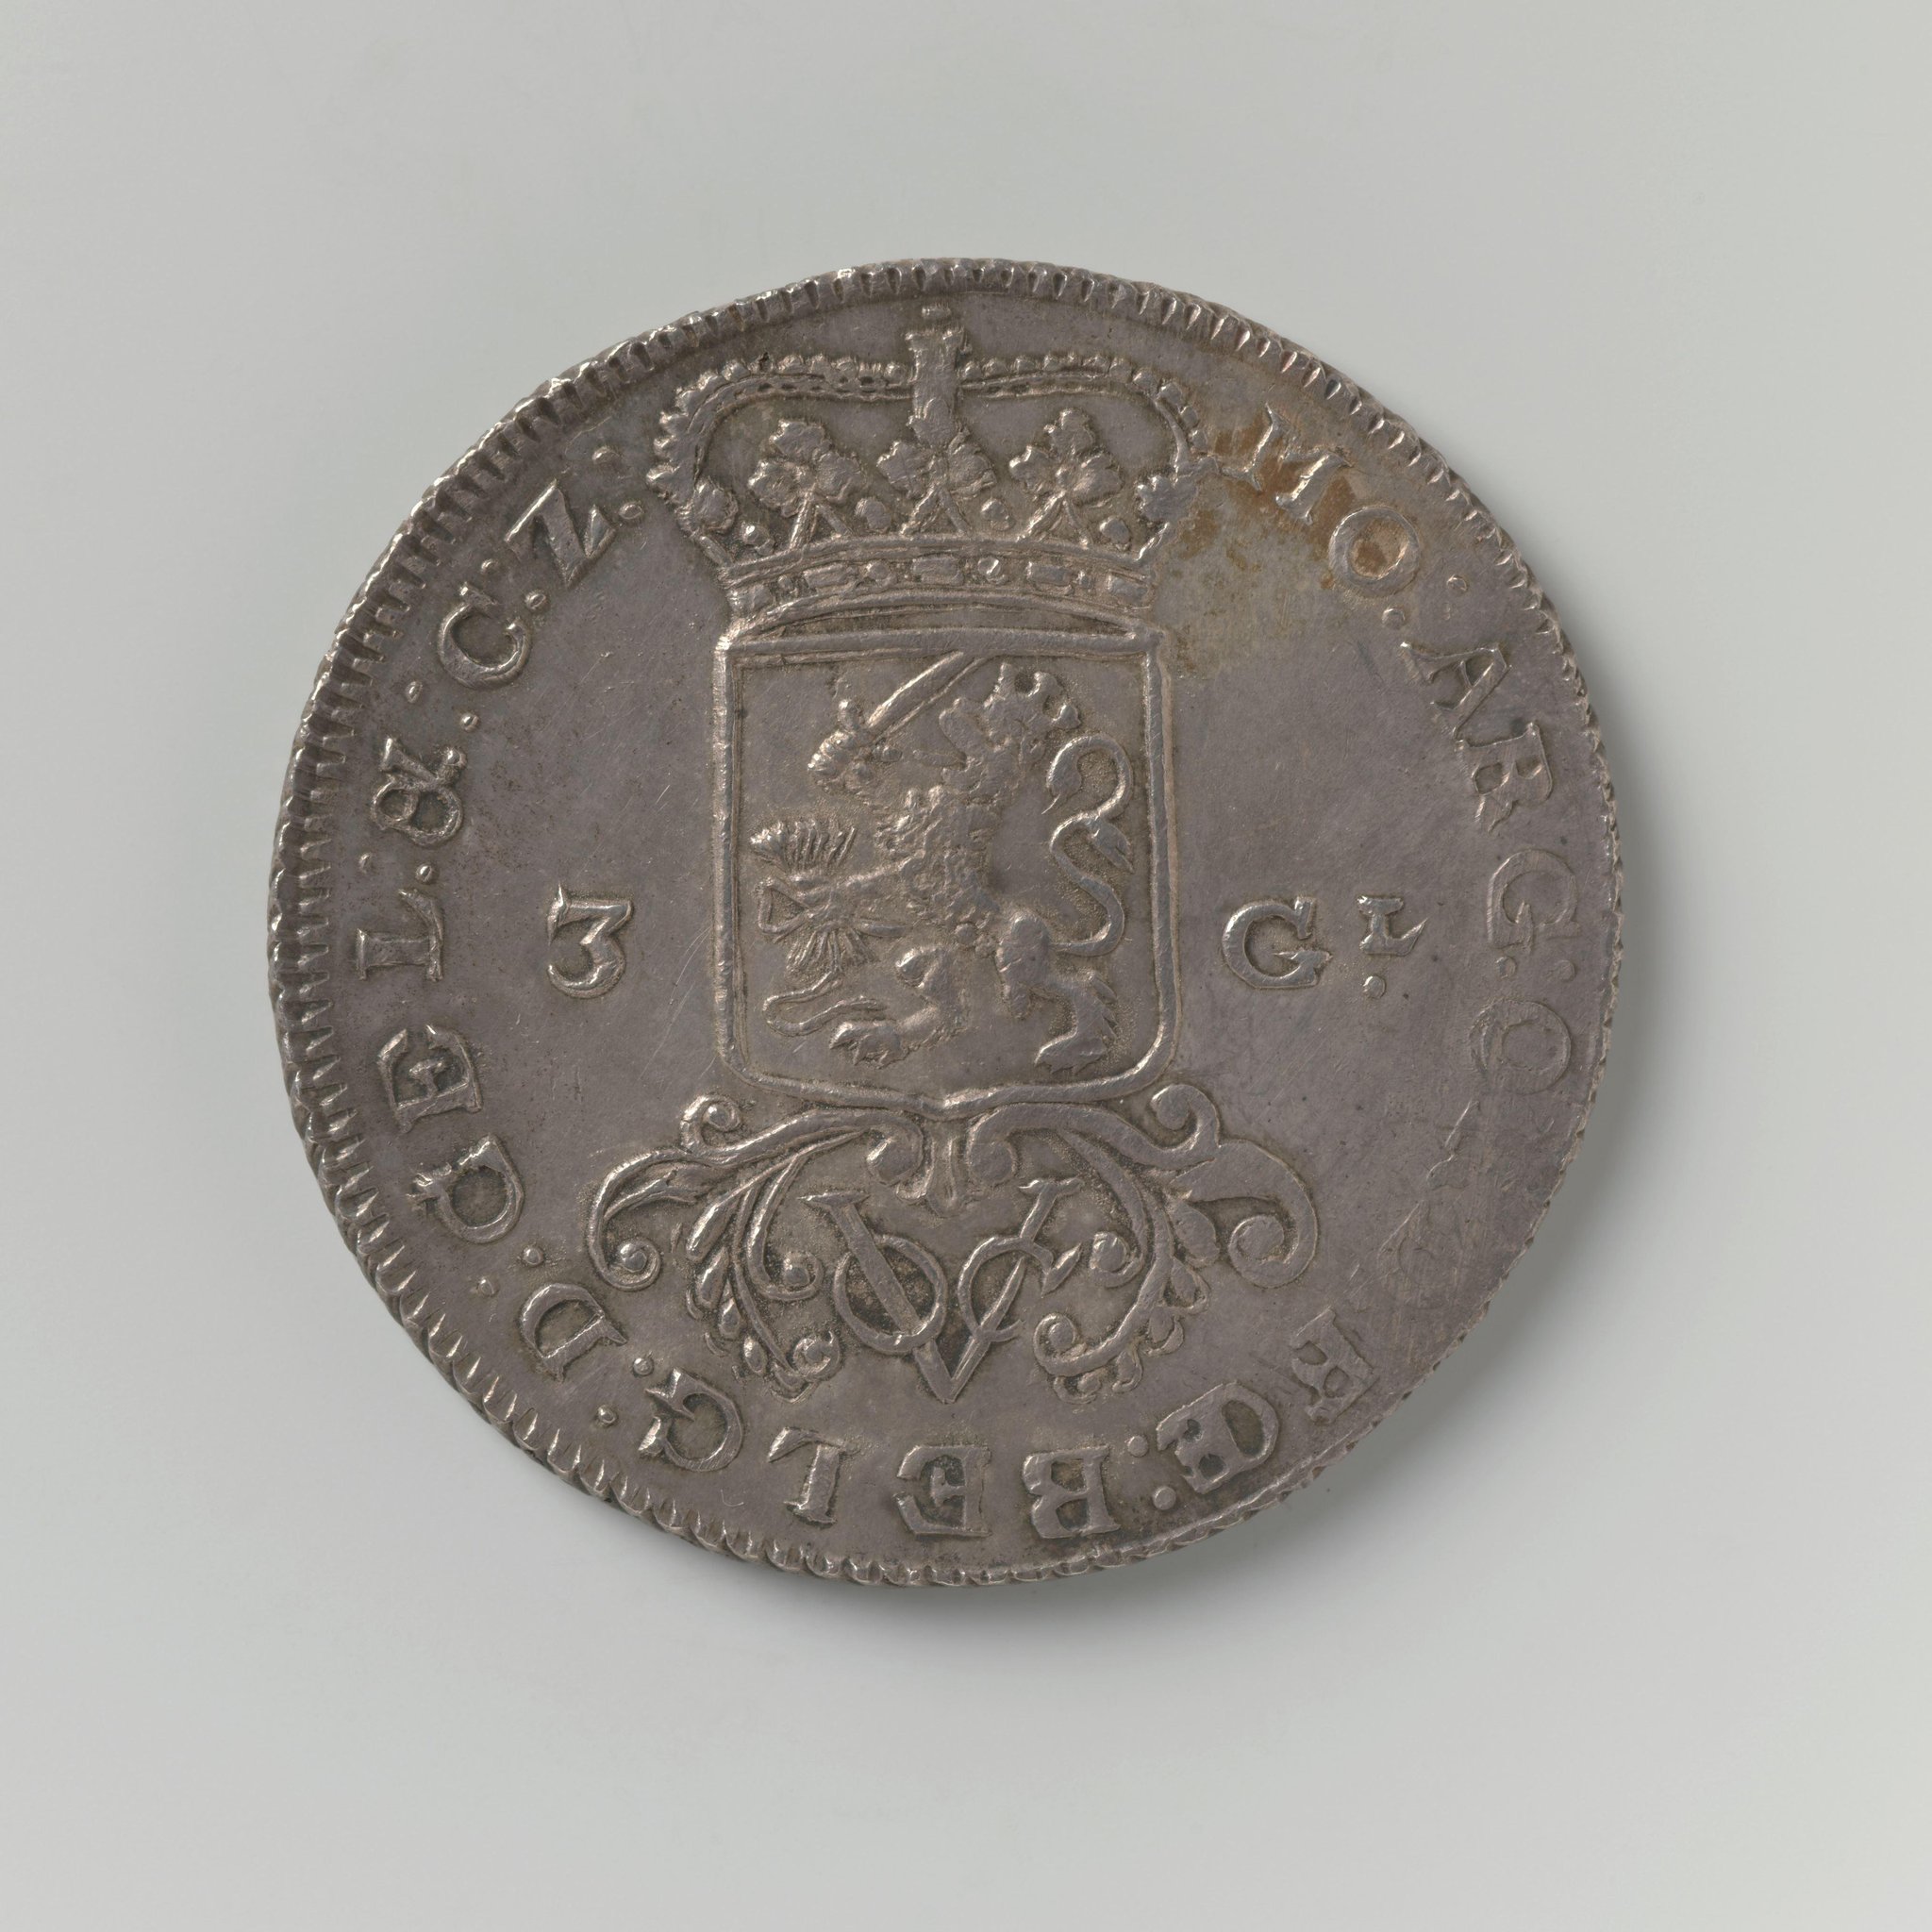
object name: coin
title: VOC, drie gulden, Gelderland, 1786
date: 1786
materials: silver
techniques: striking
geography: harderwijk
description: Zilveren munt. Voorzijde: tussen waarde-aanduiding 3 Gl. gekroond generaliteitswapenschild, waaronder cartouche, waarin monogram van de VOC. Keerzijde: Nederlandse maagd met speer, waarop vrijheidshoed, leunend op een bijbel op een altaar. Jaartal in afsnede. Kabelrand.